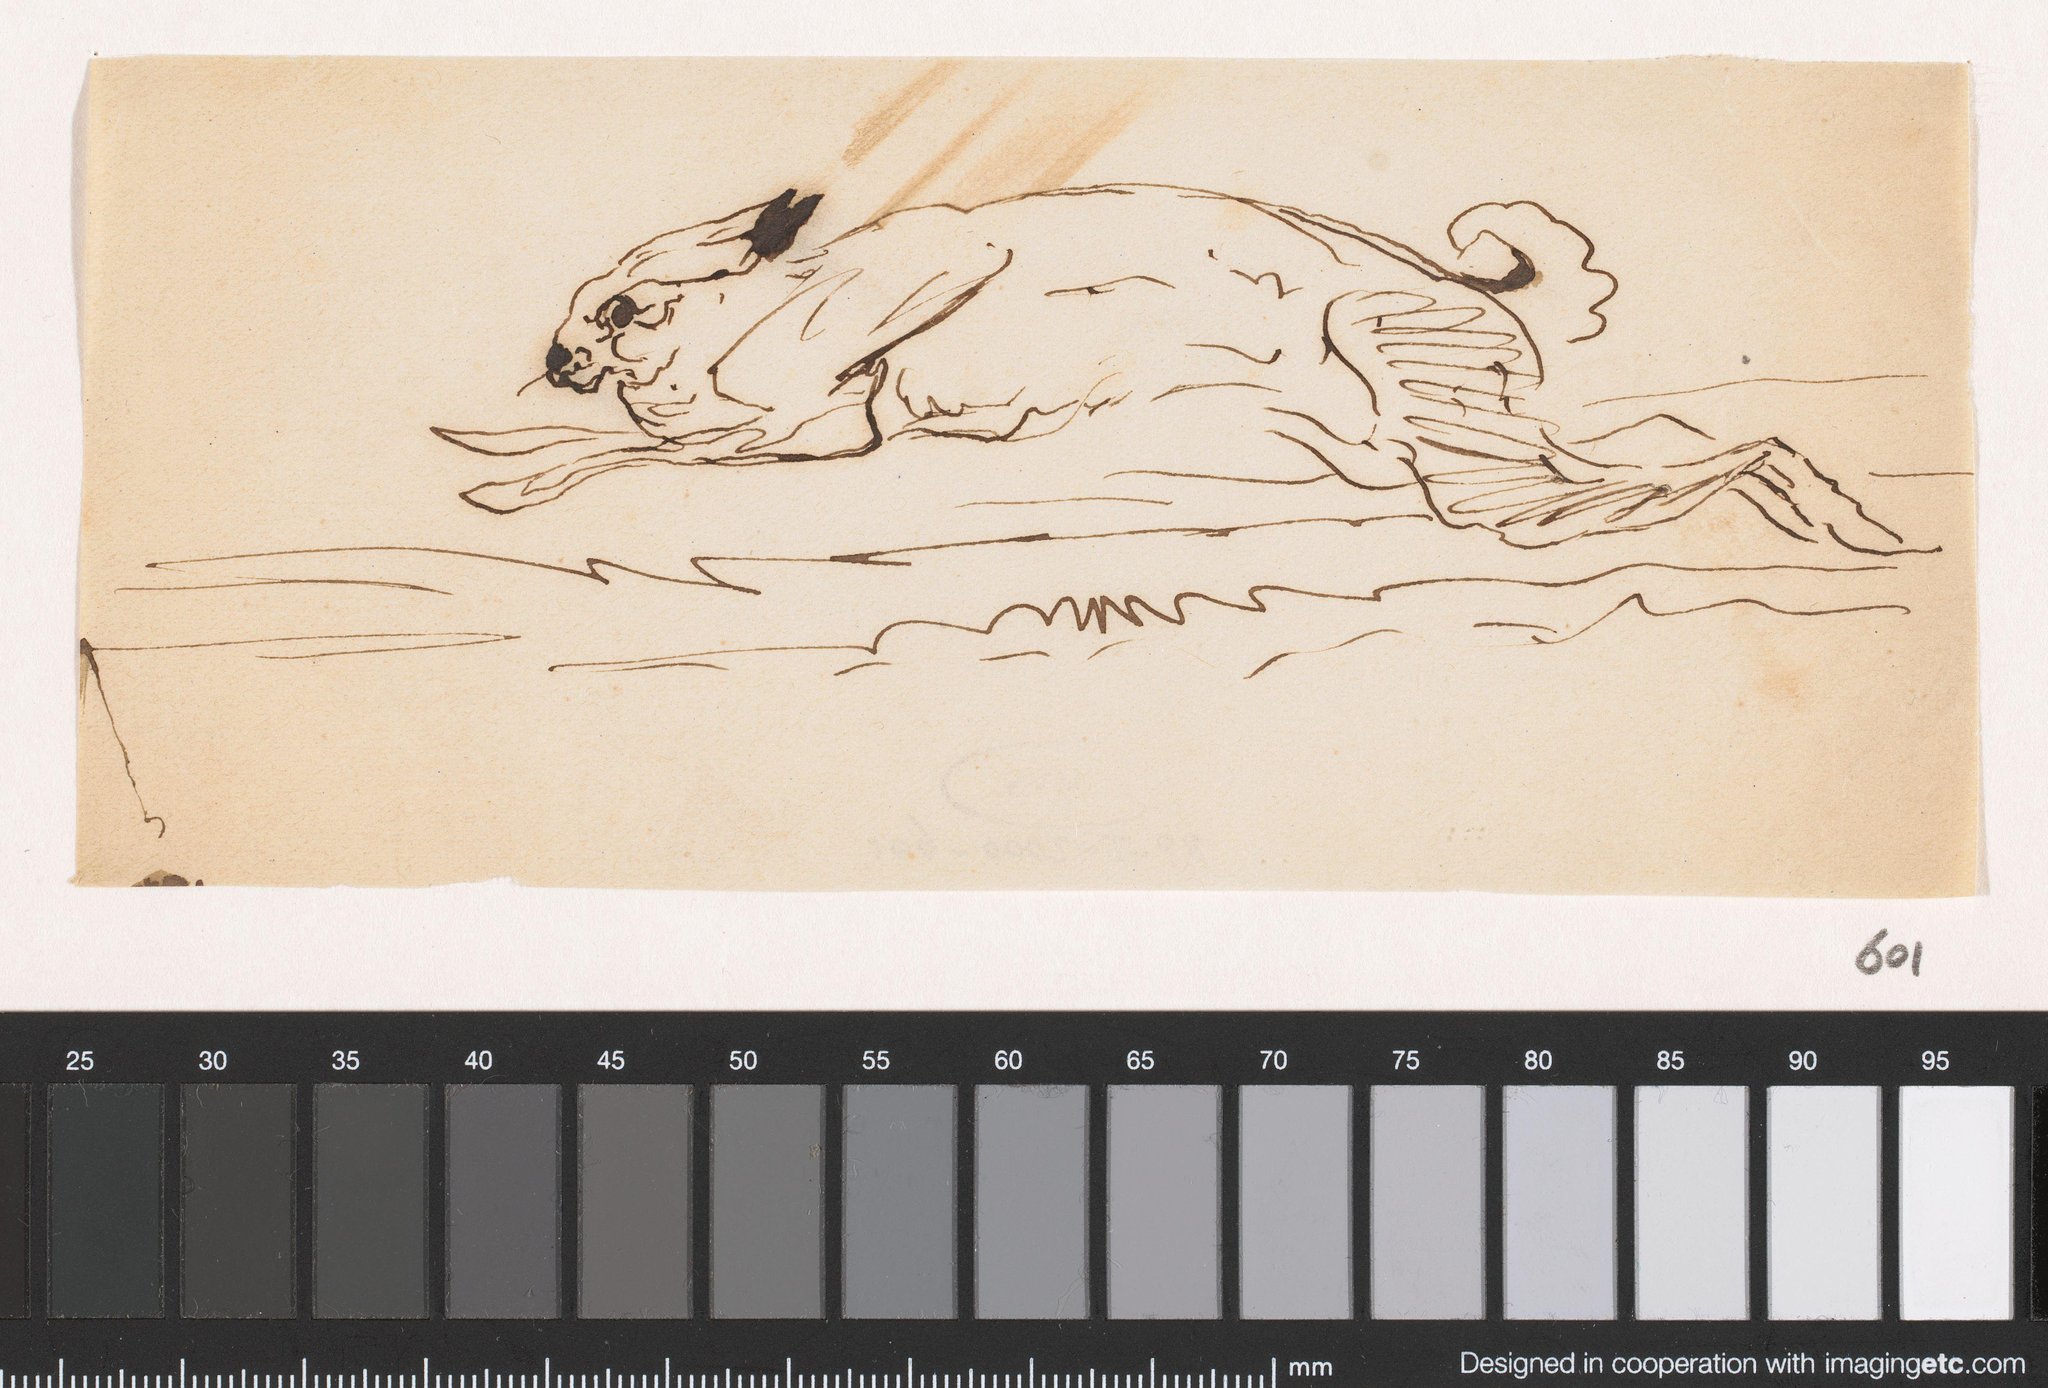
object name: drawing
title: Haas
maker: johannes tavenraat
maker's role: draughtsman, painter, print maker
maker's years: 1809-1881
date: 1840-1880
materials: ink, paper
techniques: pen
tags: rodents: hare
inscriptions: collector's mark: Lugt 2228